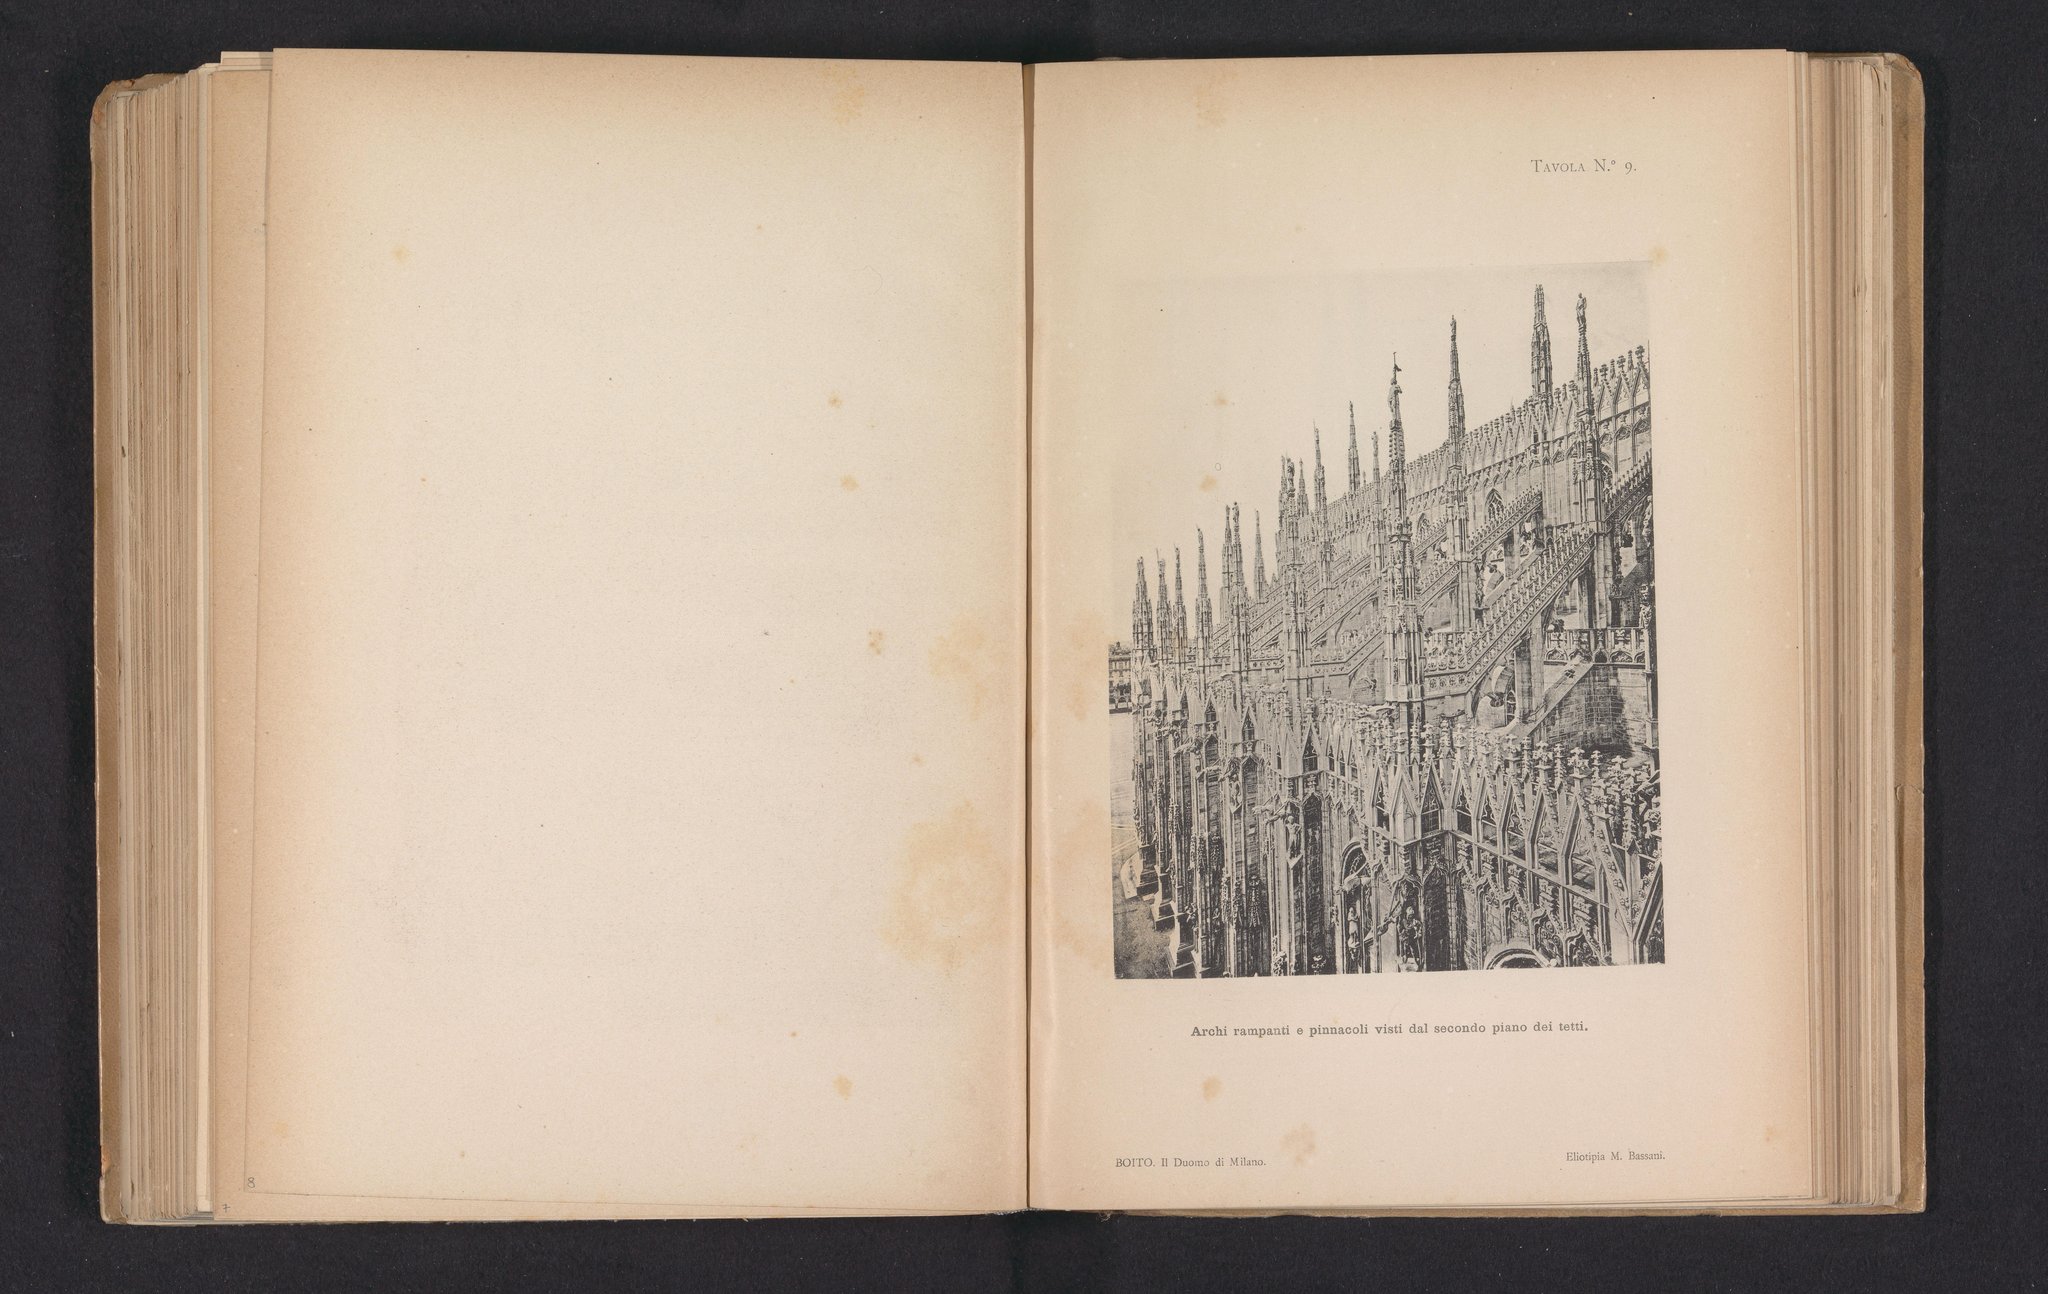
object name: photomechanical print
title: Archi rampanti e pinnacoli visti dal secondo piano dei tetti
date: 1879-1889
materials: paper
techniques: photograph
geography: milan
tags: roof (of house or building), church (exterior), piece of sculpture, reproduction of a piece of sculpture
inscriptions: number: ‘Tavola No. 9.’